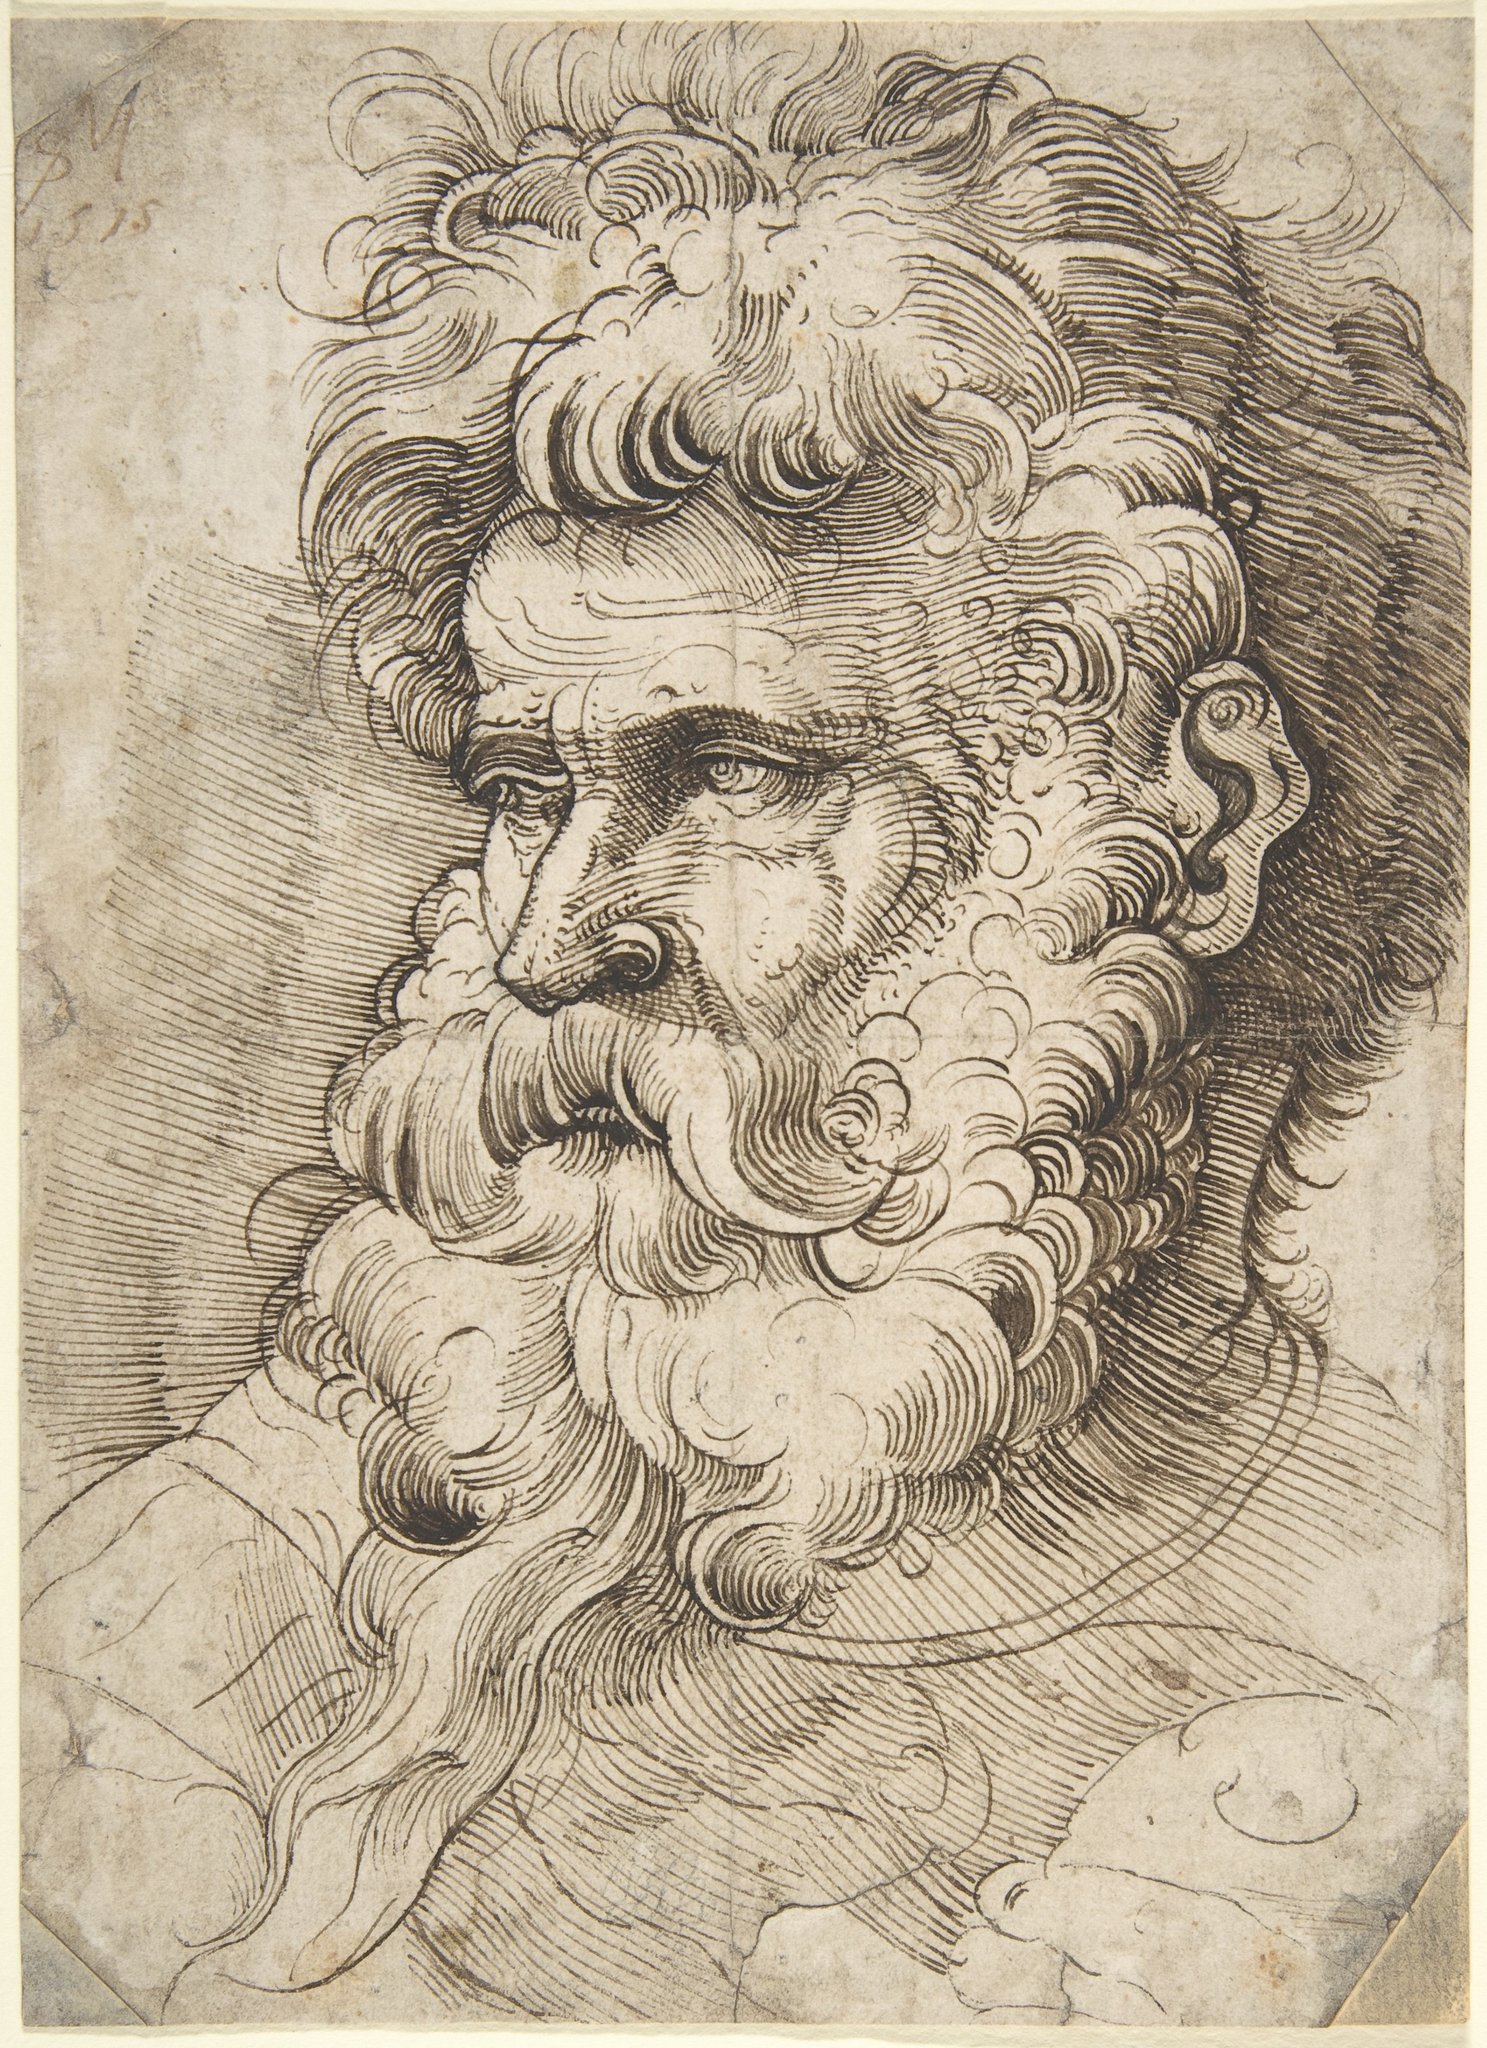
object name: drawing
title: Head of a Bearded Man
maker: monogrammist sm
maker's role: artist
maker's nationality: german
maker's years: 1515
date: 1515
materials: ink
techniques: pen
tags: heads,men